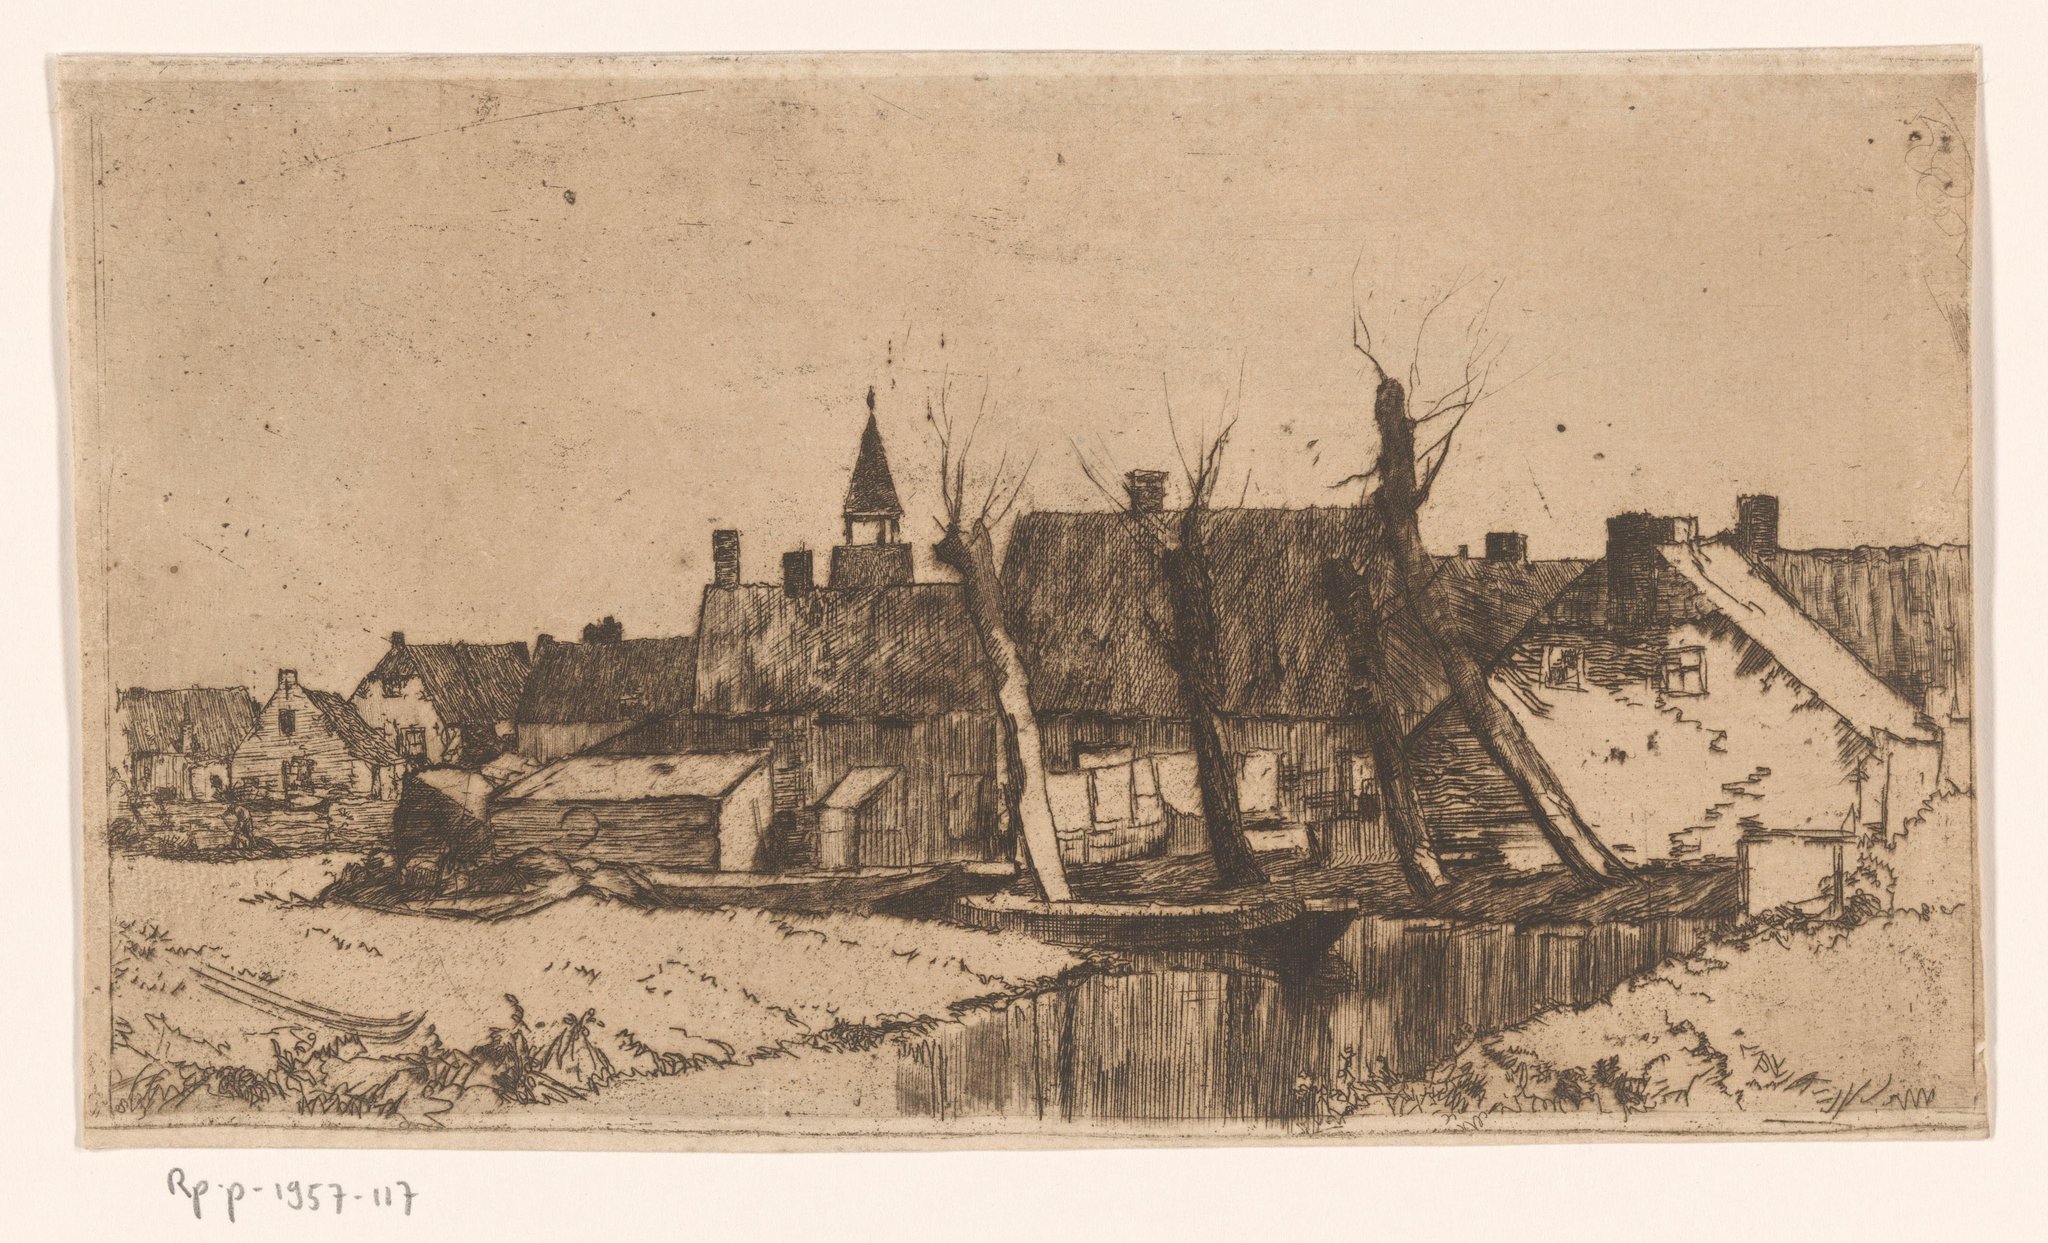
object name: print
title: Dorp aan een vaart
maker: chris van der windt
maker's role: print maker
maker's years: 1877-1952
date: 1887-1952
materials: paper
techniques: drypoint, etching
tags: prospect of village, silhouette of village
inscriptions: collector's mark: Lugt 2228